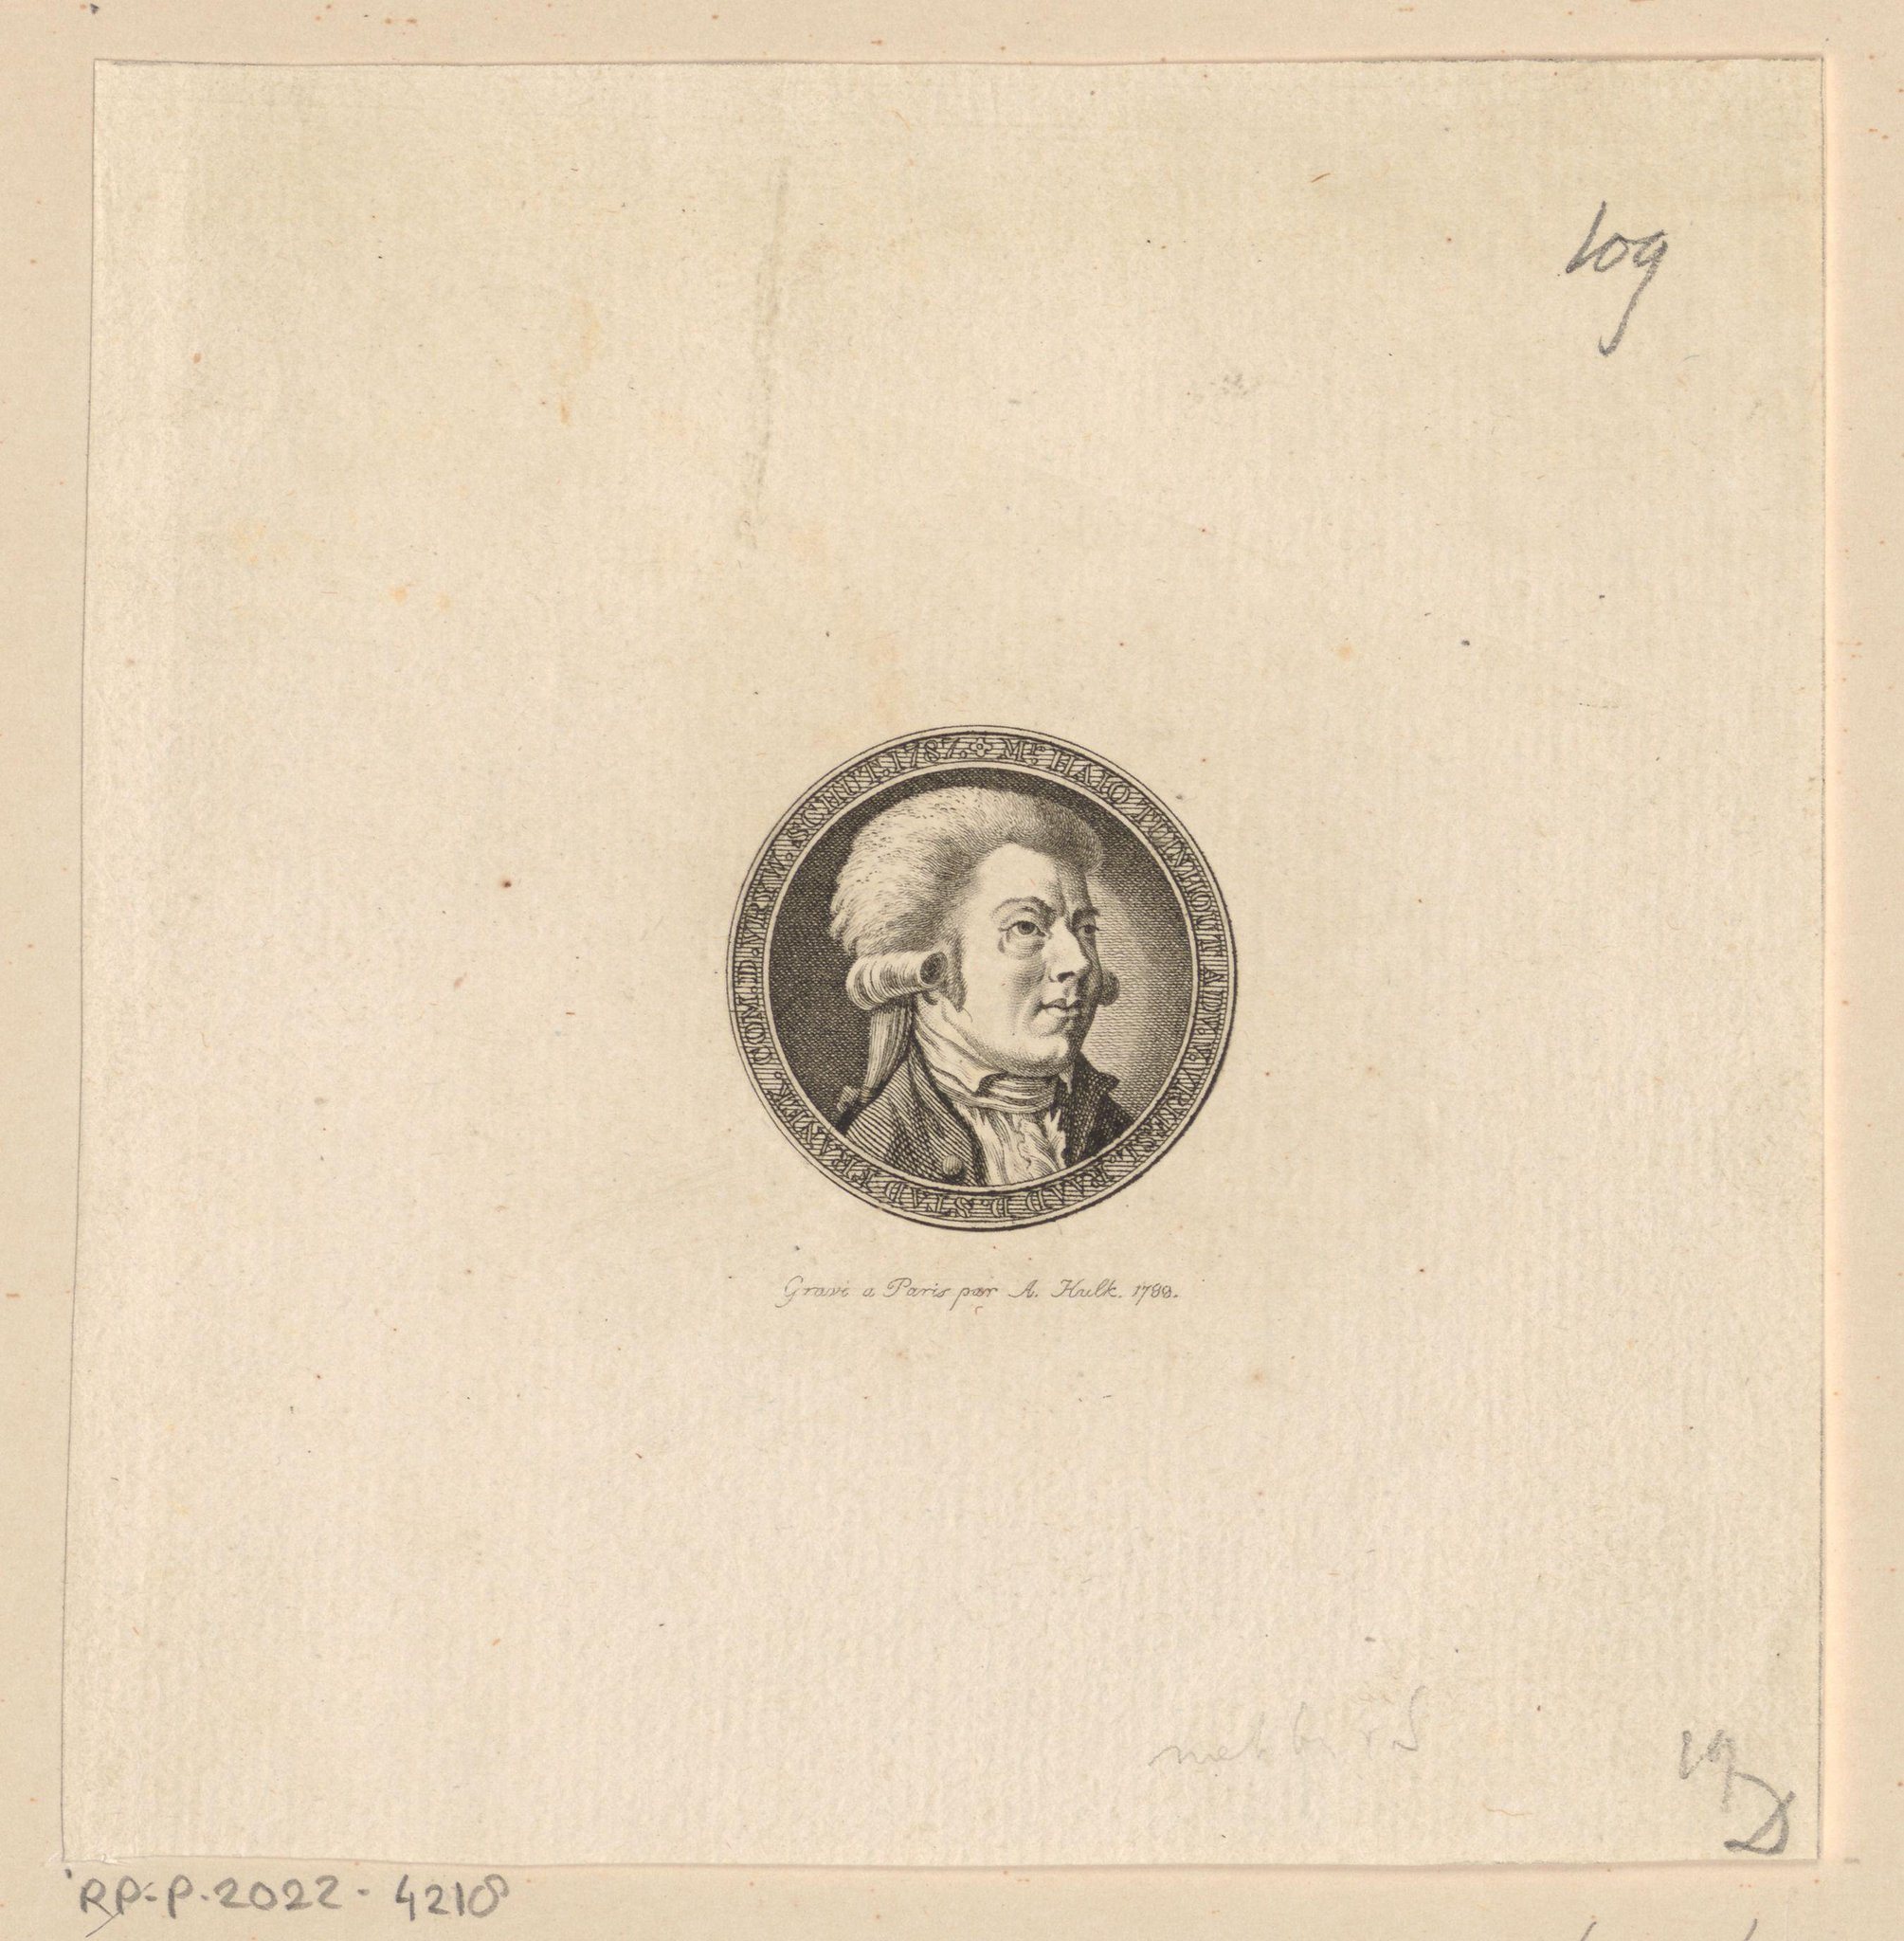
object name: print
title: portretten van patriotten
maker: abraham jacobsz. hulk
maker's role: print maker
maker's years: 1751-1817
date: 1788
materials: paper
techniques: engraving, etching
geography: paris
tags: historical persons, politician, e.g. party leader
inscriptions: collector's mark: Lugt 2228